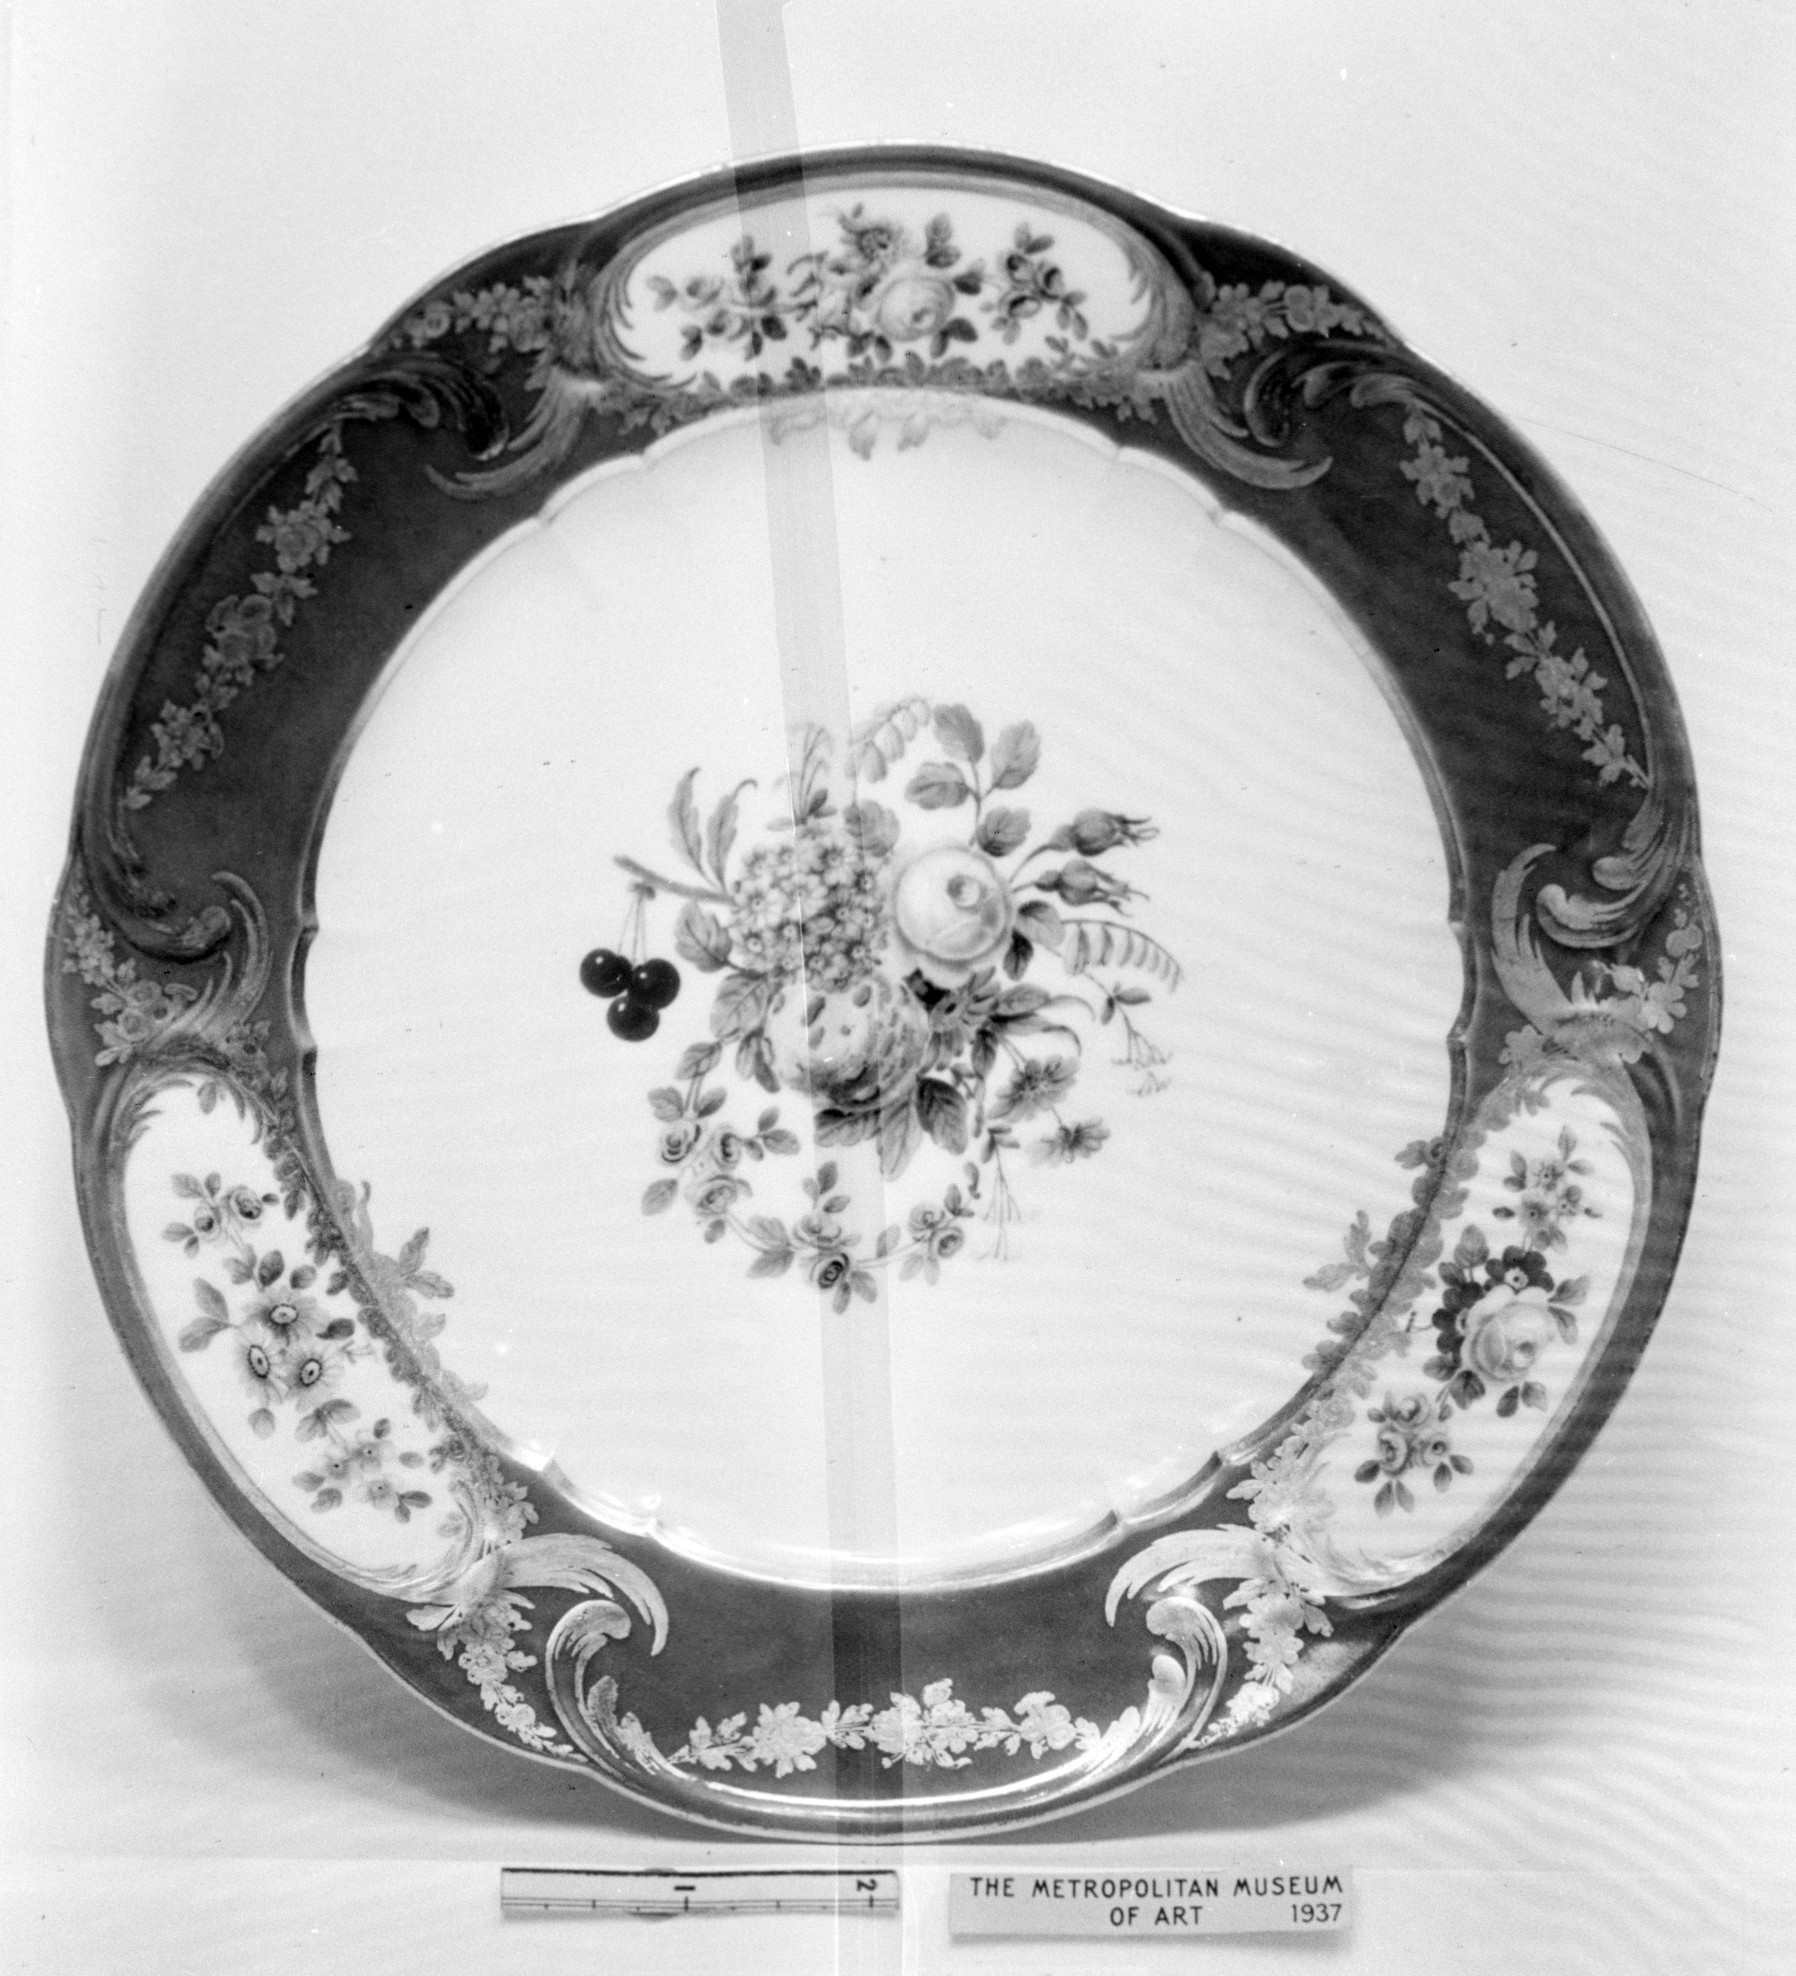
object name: plate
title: Plate (Assiette à palmes) (1 of 102) (part of a service)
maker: sèvres manufactory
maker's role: manufactory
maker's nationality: french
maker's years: 1740-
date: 1786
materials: soft paste porcelain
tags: fruit,flowers